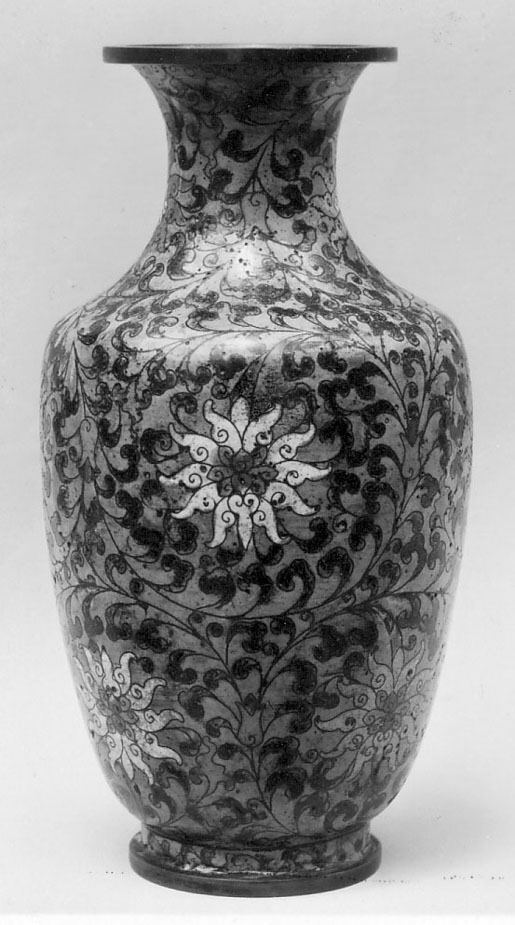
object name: vase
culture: chinese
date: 1662-1722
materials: copper, enamel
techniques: enamel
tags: flowers